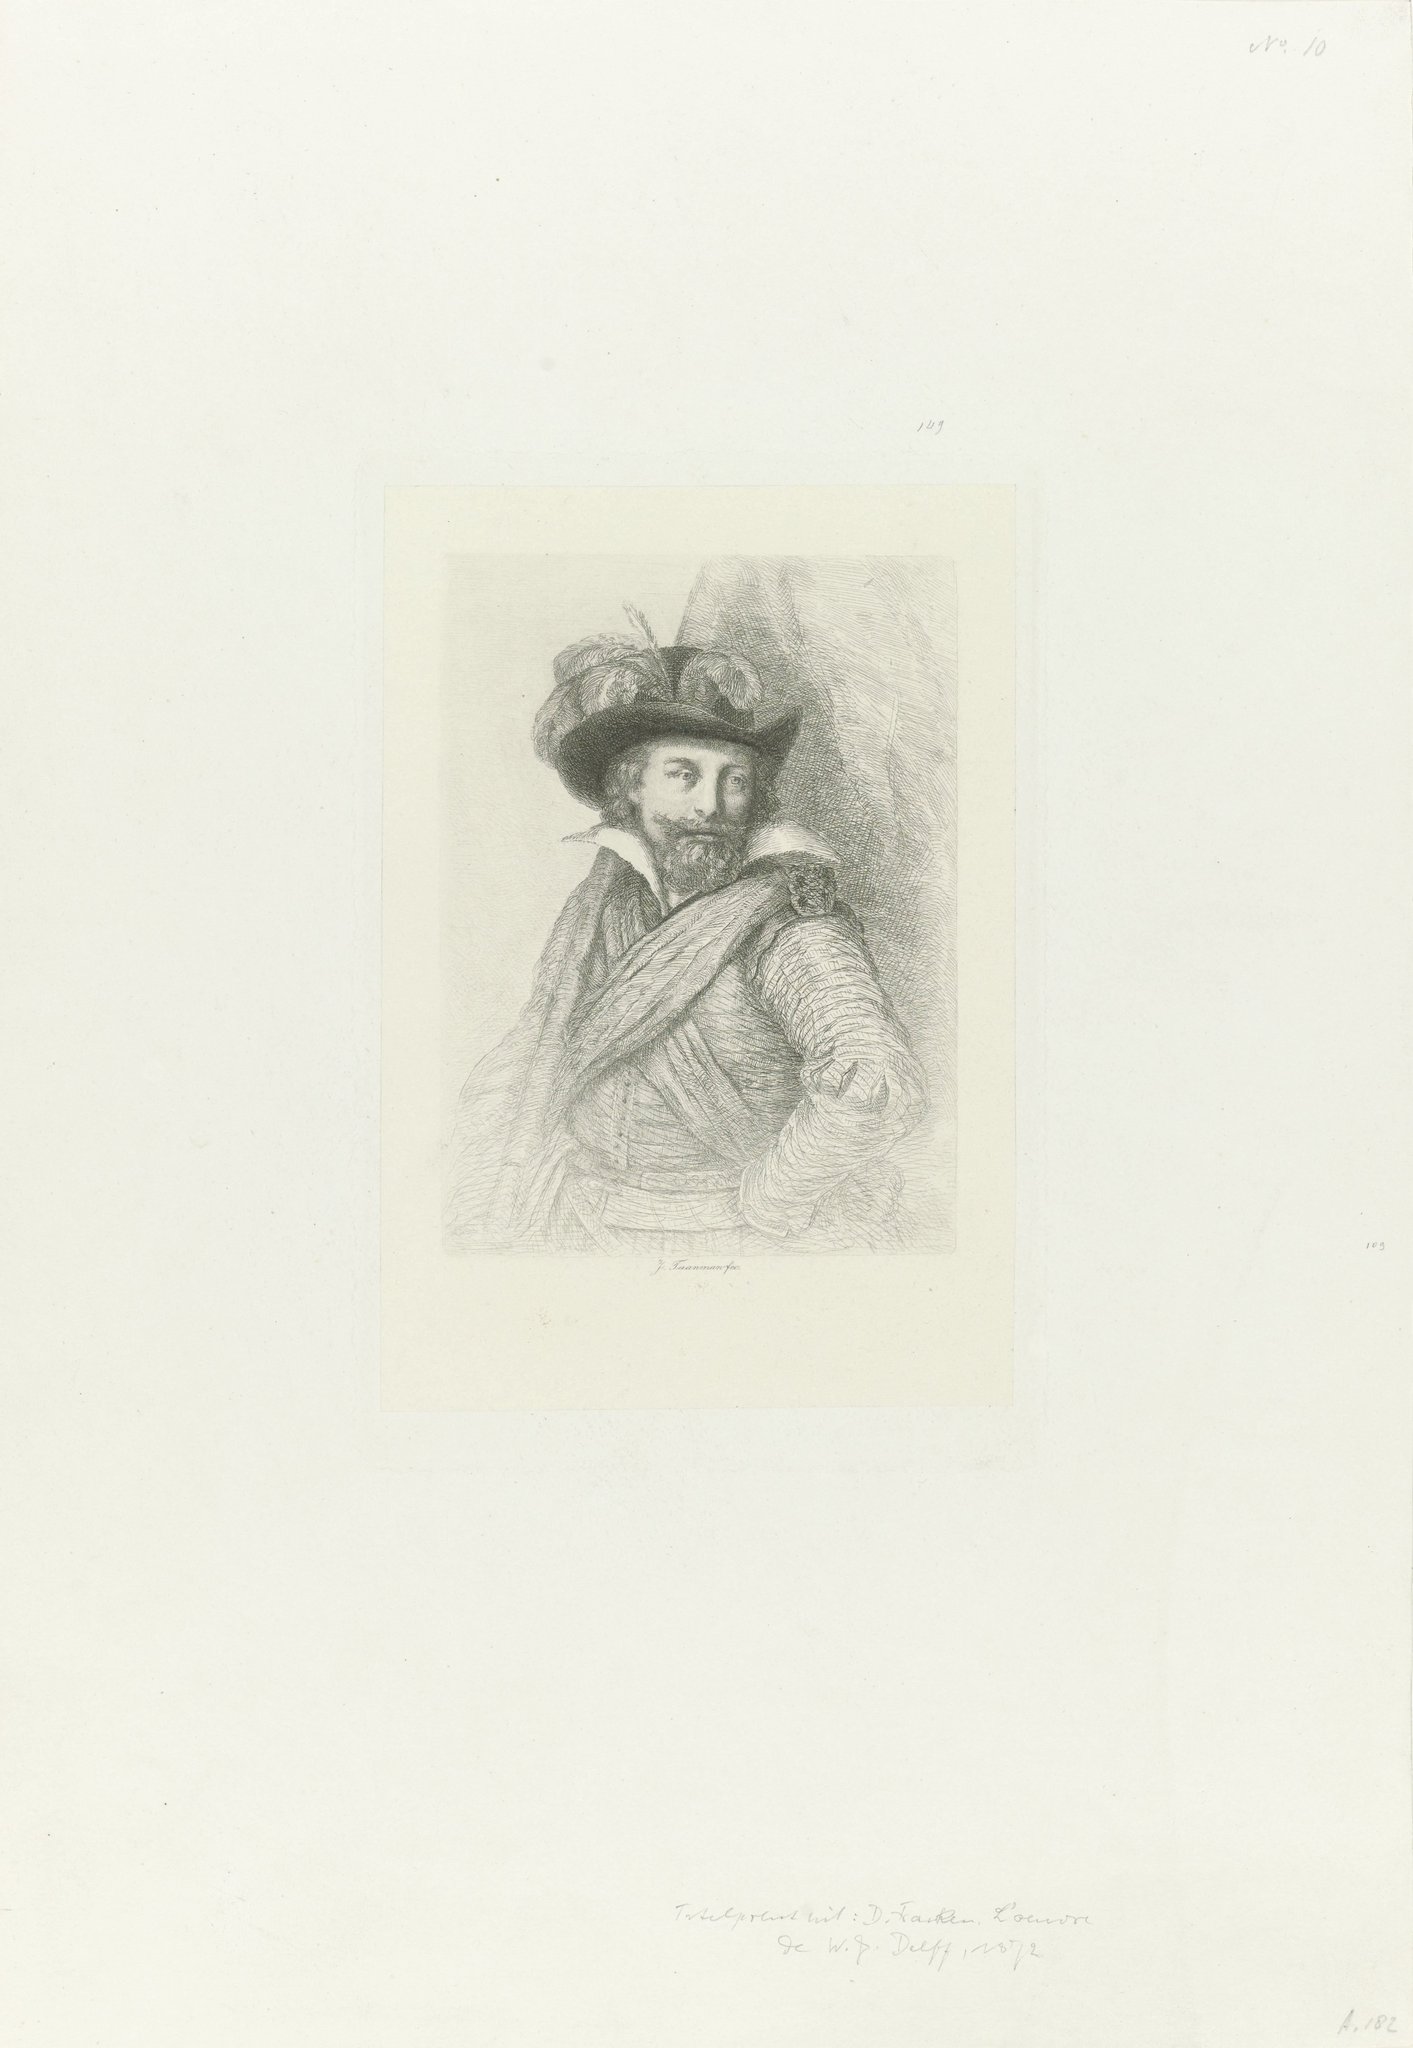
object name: print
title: Portret van Willem Jacobsz. Delff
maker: jacob taanman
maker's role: draughtsman, print maker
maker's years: 1836-1923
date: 1872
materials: paper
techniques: etching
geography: amsterdam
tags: delft, print maker, draughtsman, willem jacobsz delff, portrait, self-portrait of artist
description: Prent gebruikt in: Franken Dzn., Daniel. L'oeuvre de Willem Jacobszoon Delff décrit. Amsterdam: Van Gogh 1872.